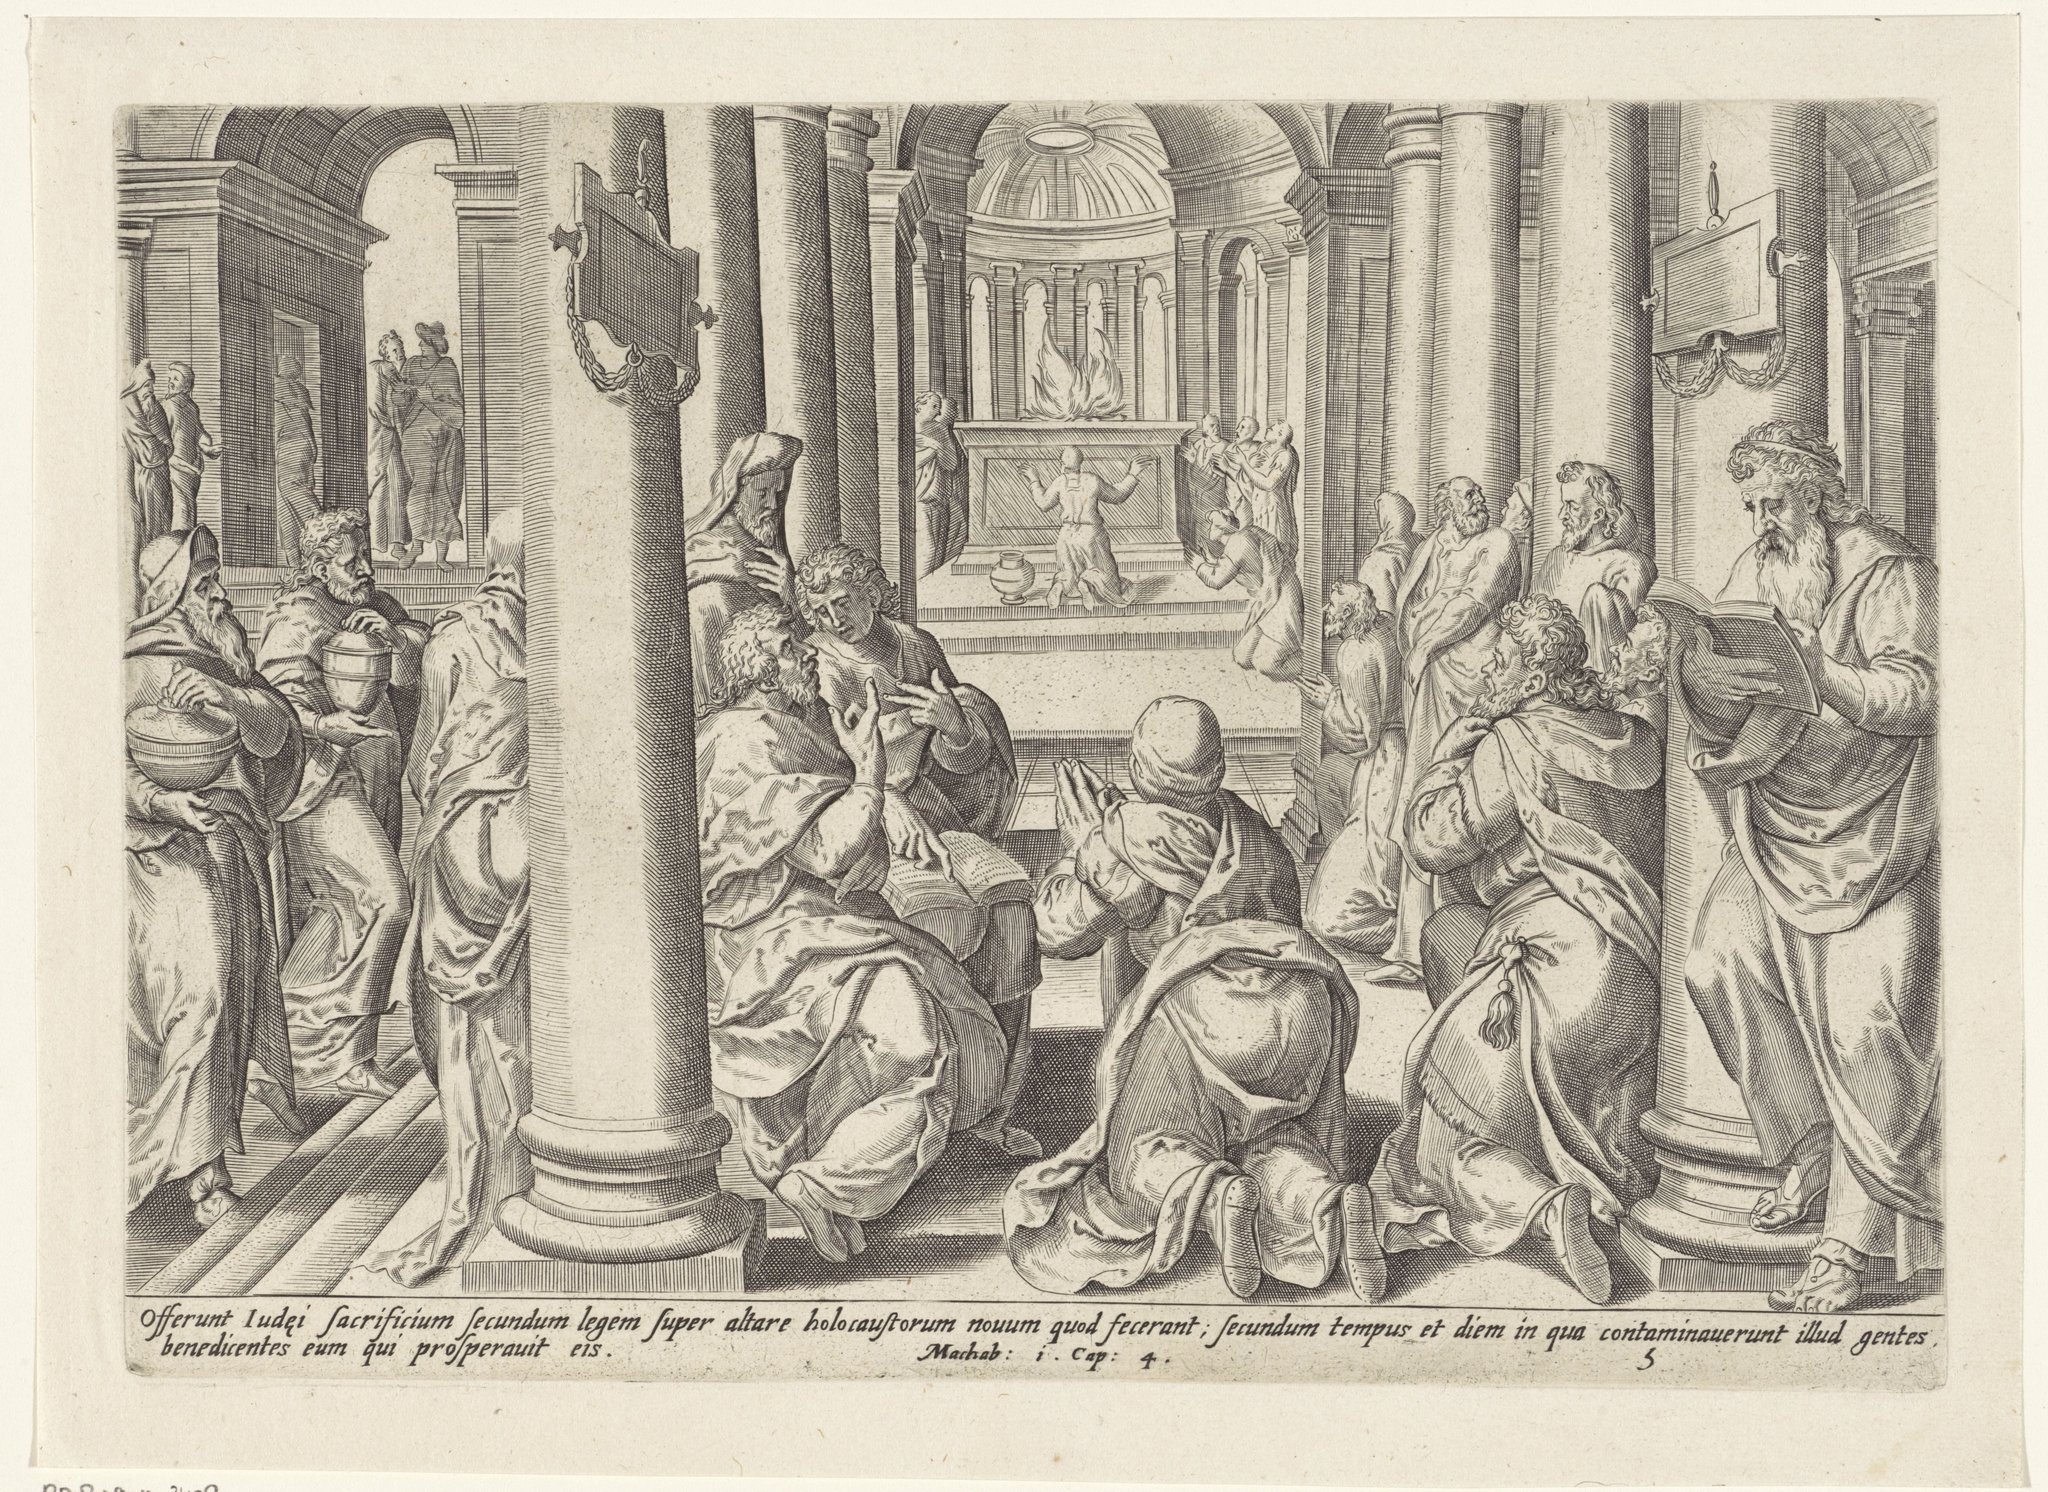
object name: print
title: Nieuwe altaar ingewijd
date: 1572-1576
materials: paper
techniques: engraving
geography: antwerp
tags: judas maccabeus has the temple purified and re-dedicated (1 maccabees 4:36-58)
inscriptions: collector's mark: Lugt 2228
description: Het nieuwe altaar in de tempel van Jeruzalem wordt ingewijd, terwijl de Israëlieten zingen. Anderen brengen offers mee. Op het nieuwe altaar brandt een offer. Onder de voorstelling een verwijzing in het Latijn naar de Bijbeltekst in 1 Makk. 4.